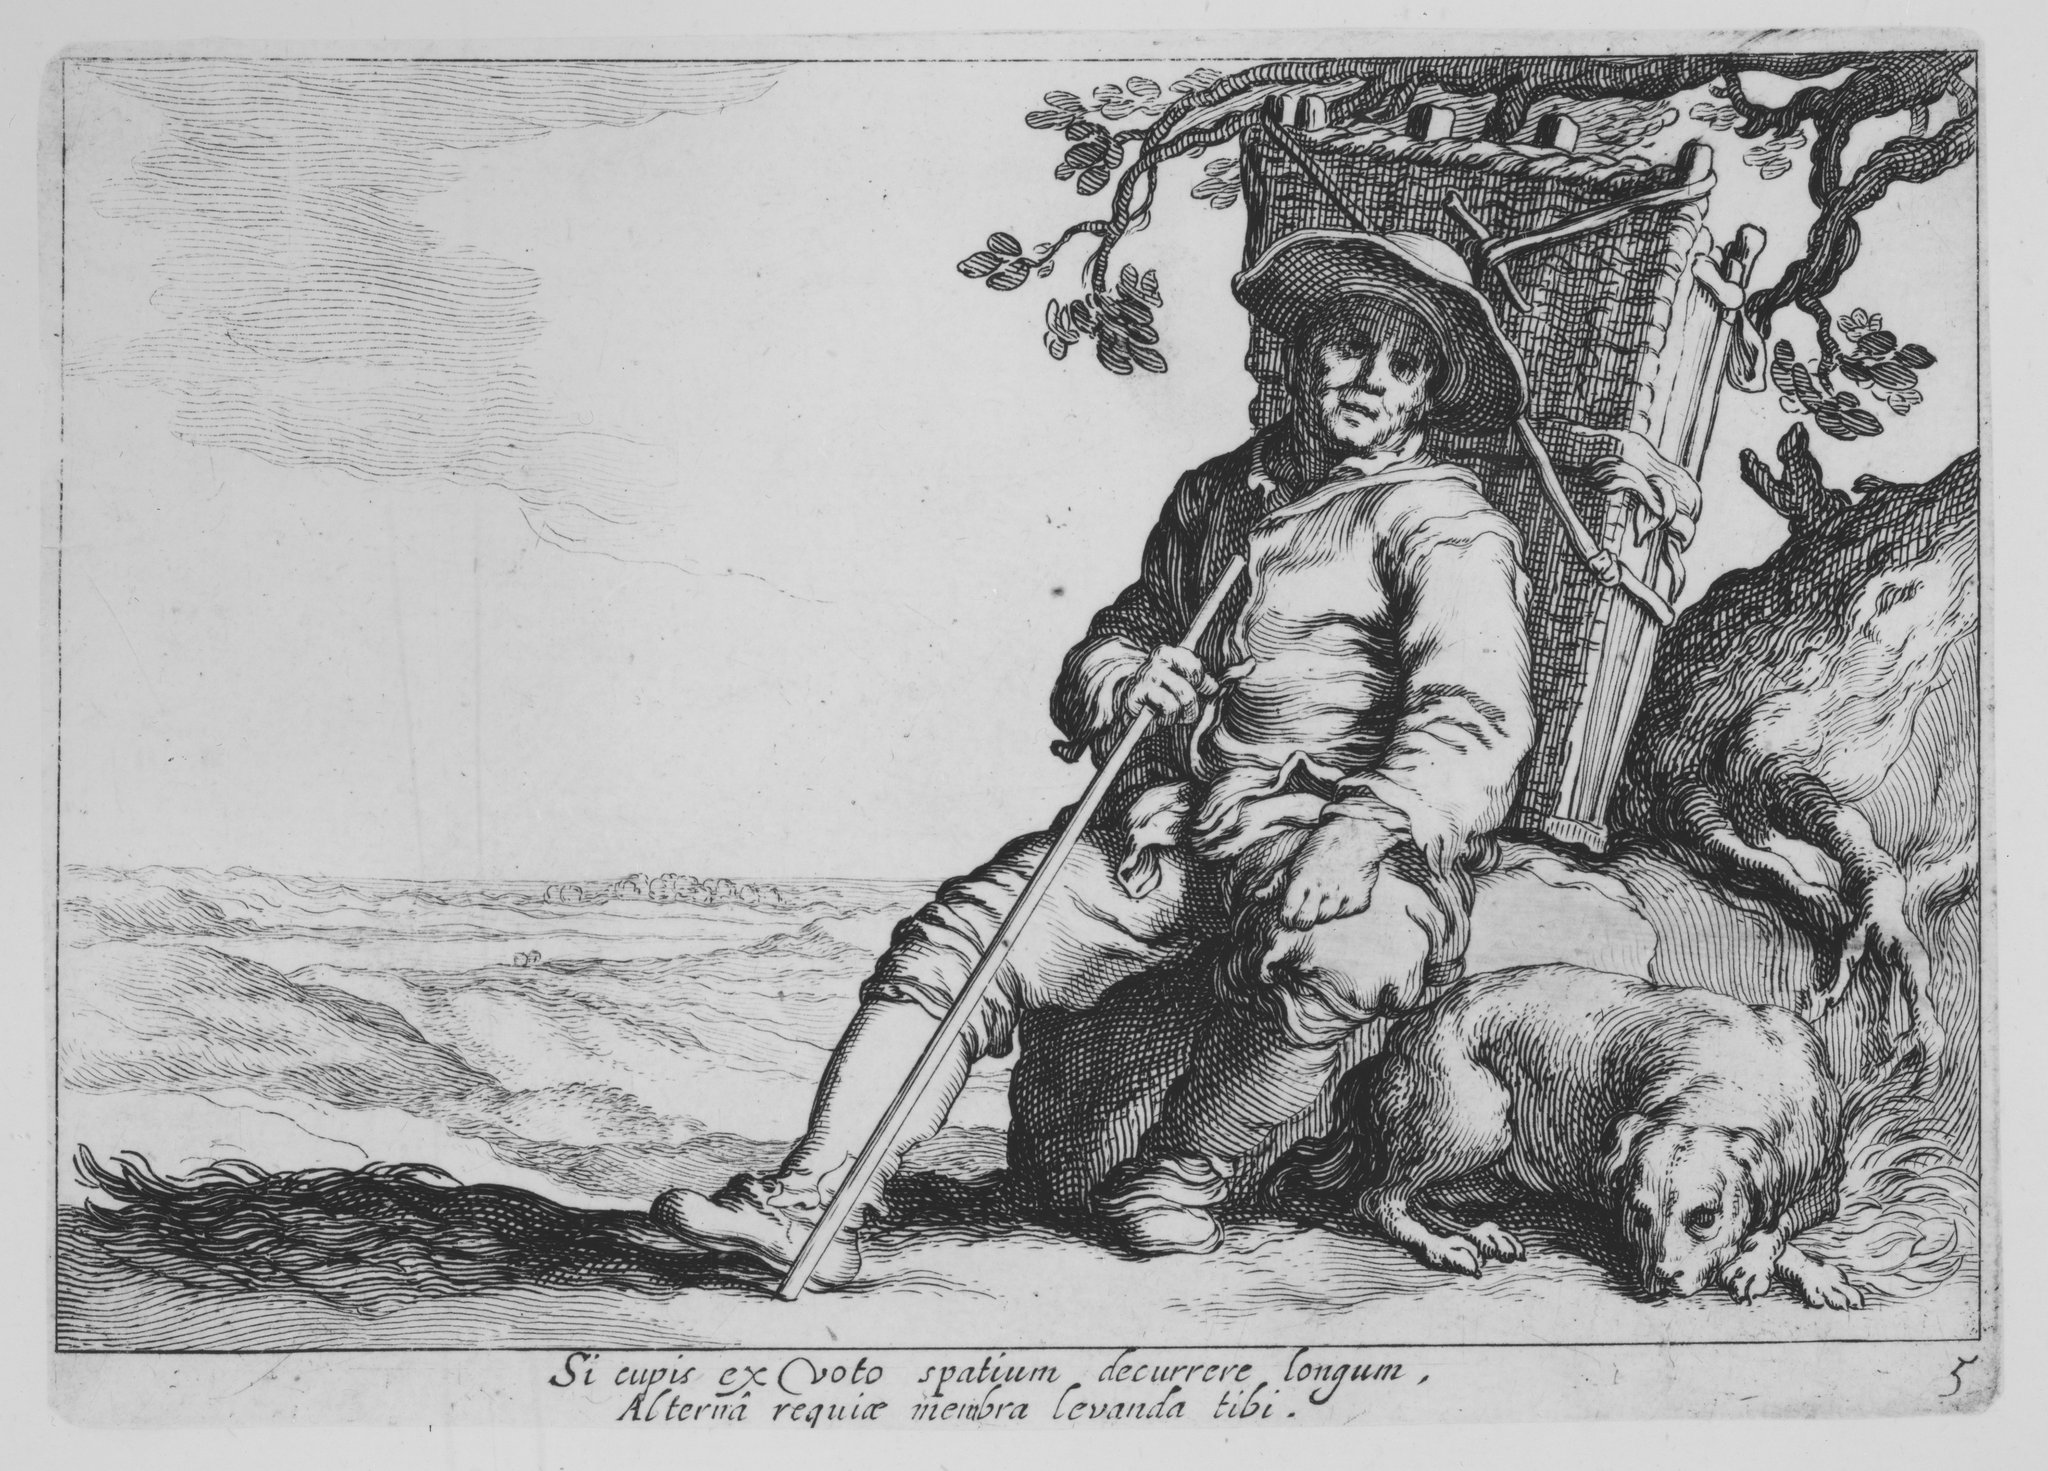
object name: print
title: Traveler with Dog, from "Sixteen Peasant Subjects"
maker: cornelis bloemaert (ii)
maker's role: artist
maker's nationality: dutch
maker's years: 1603-1684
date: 1601-1700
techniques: etching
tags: men,dogs,trees